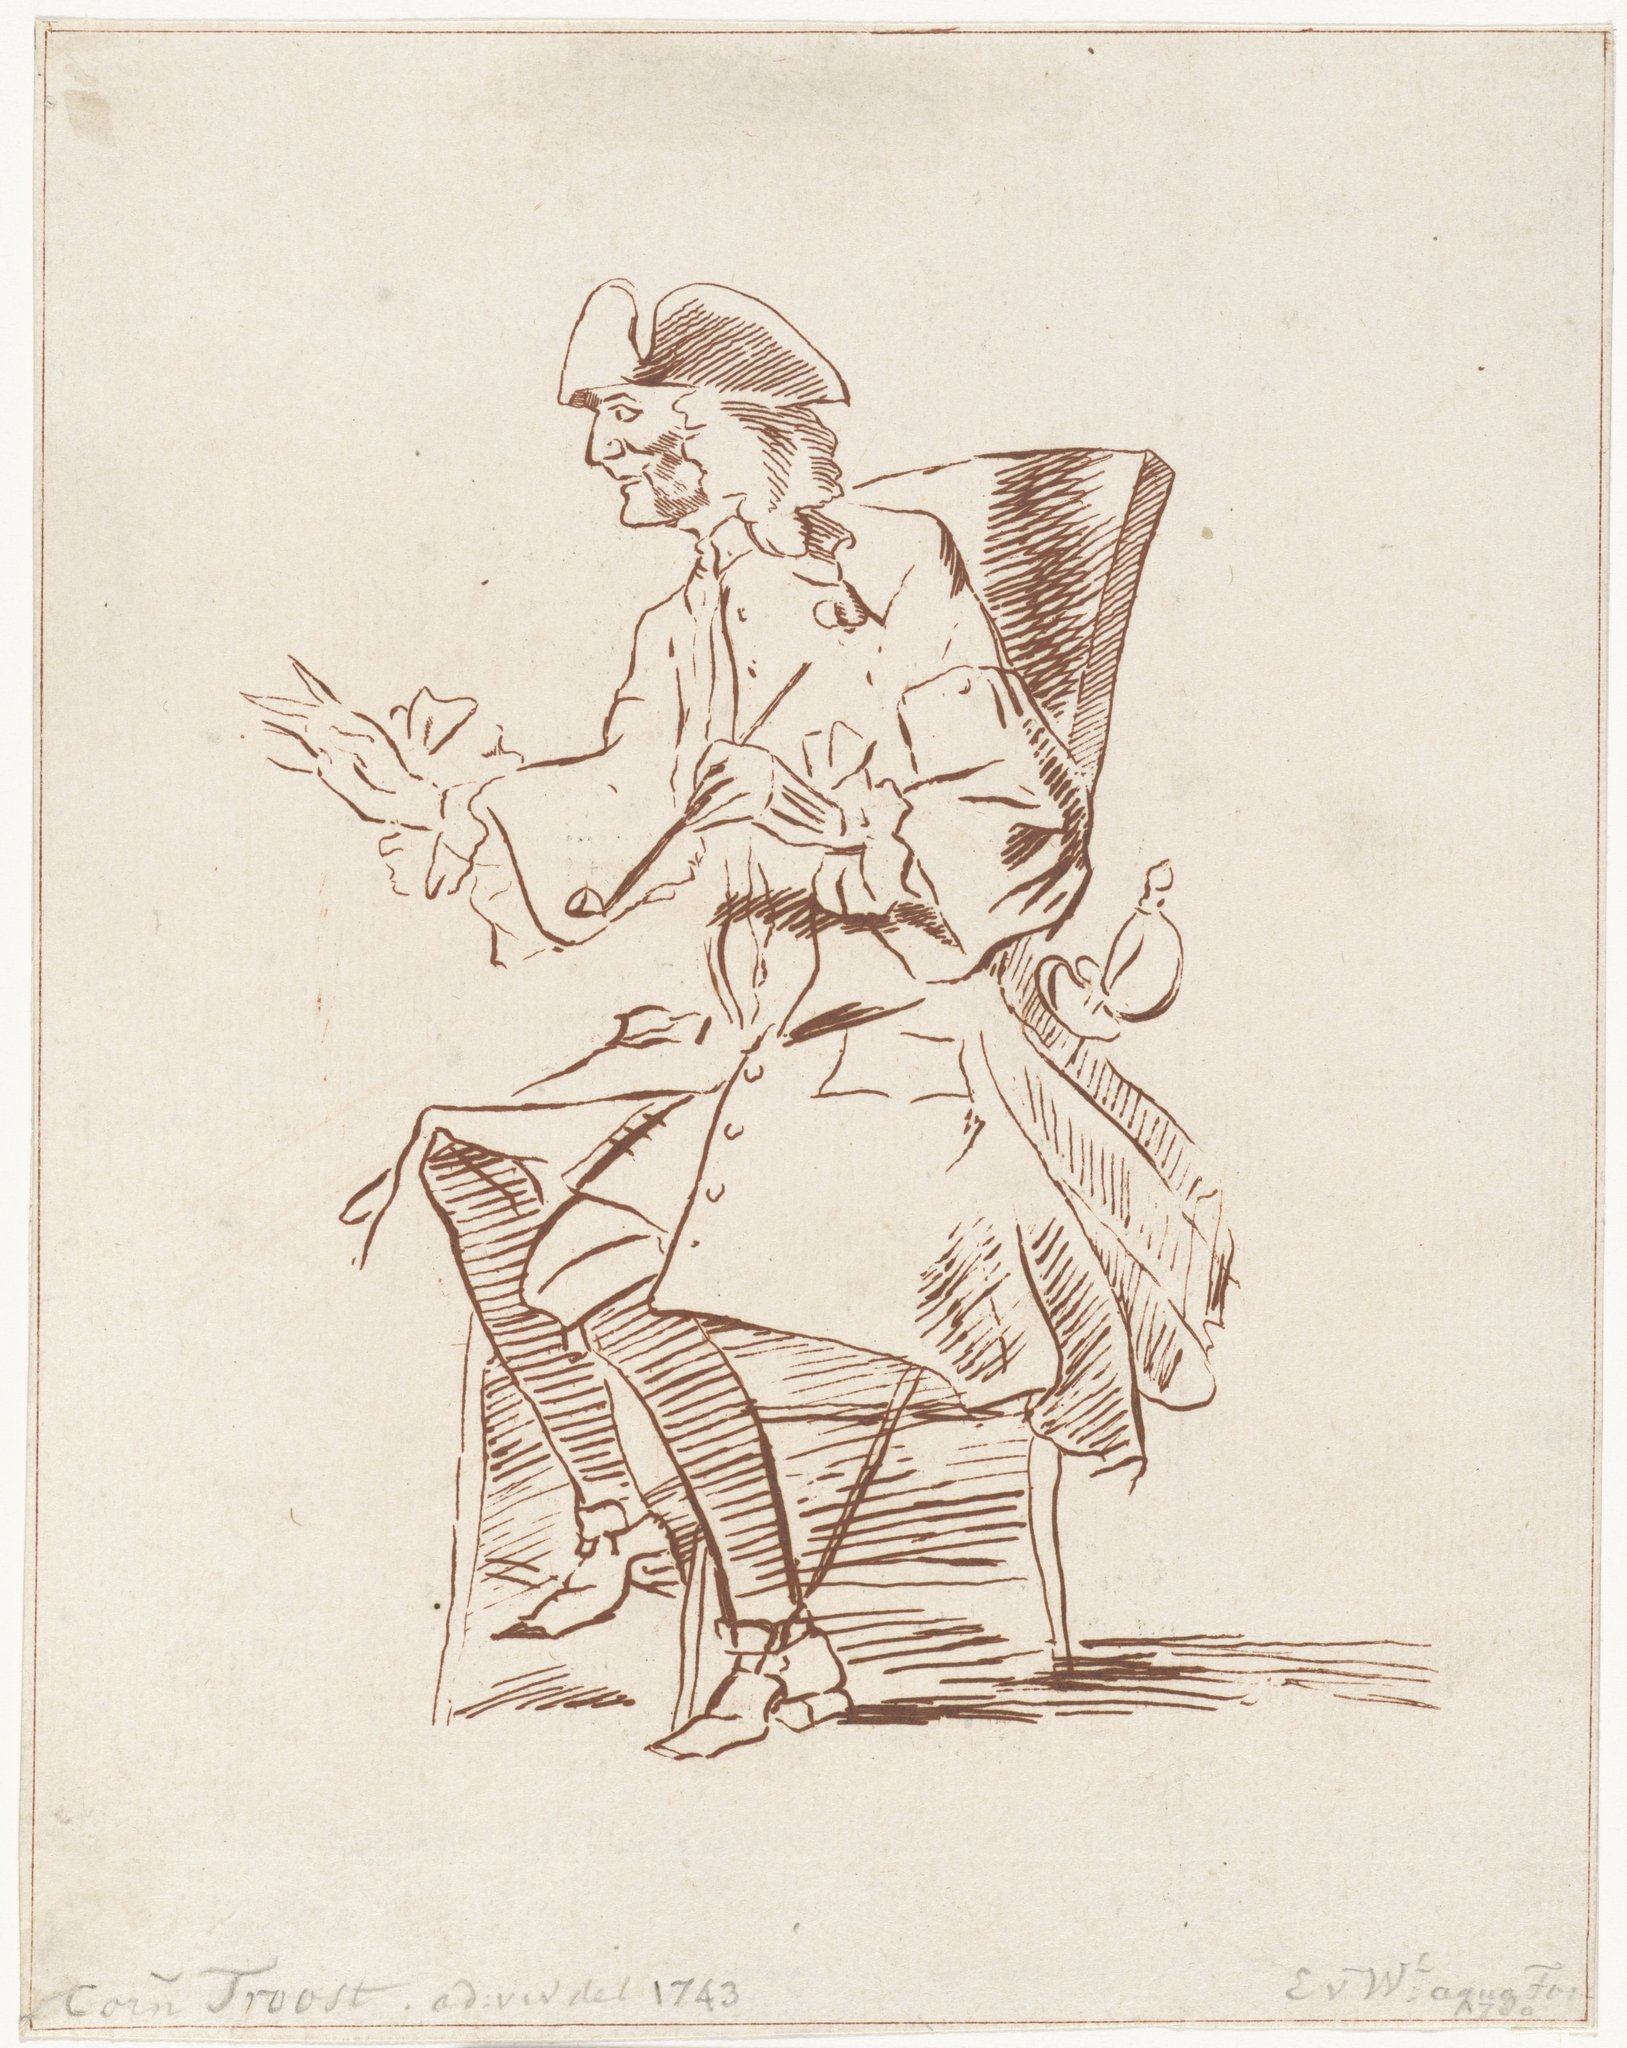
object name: print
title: Portret van Jacob Carpi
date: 1743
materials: paper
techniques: etching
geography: amsterdam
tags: sitting figure, pipe ~ tobacco, portrait, self-portrait of artist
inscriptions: dedication: ‘Geoffreerd in den Atlas van mijne vriend de Heer H.J. Roulland [sic] CPVAJC’, collector's mark: Lugt 2228, signature: ‘Corn. Troost af viv. del. 1743. E.v.W. aqua For. 1780’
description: Portret van Jacob Carpi, Joods kunstschilder en kunstverkoper te Amsterdam, ten voeten uit. Hij zit op een stoel in profiel en draagt een steek. In zijn linkerhand heeft hij een pijp. Langs zijn lichaam hangt een degen.